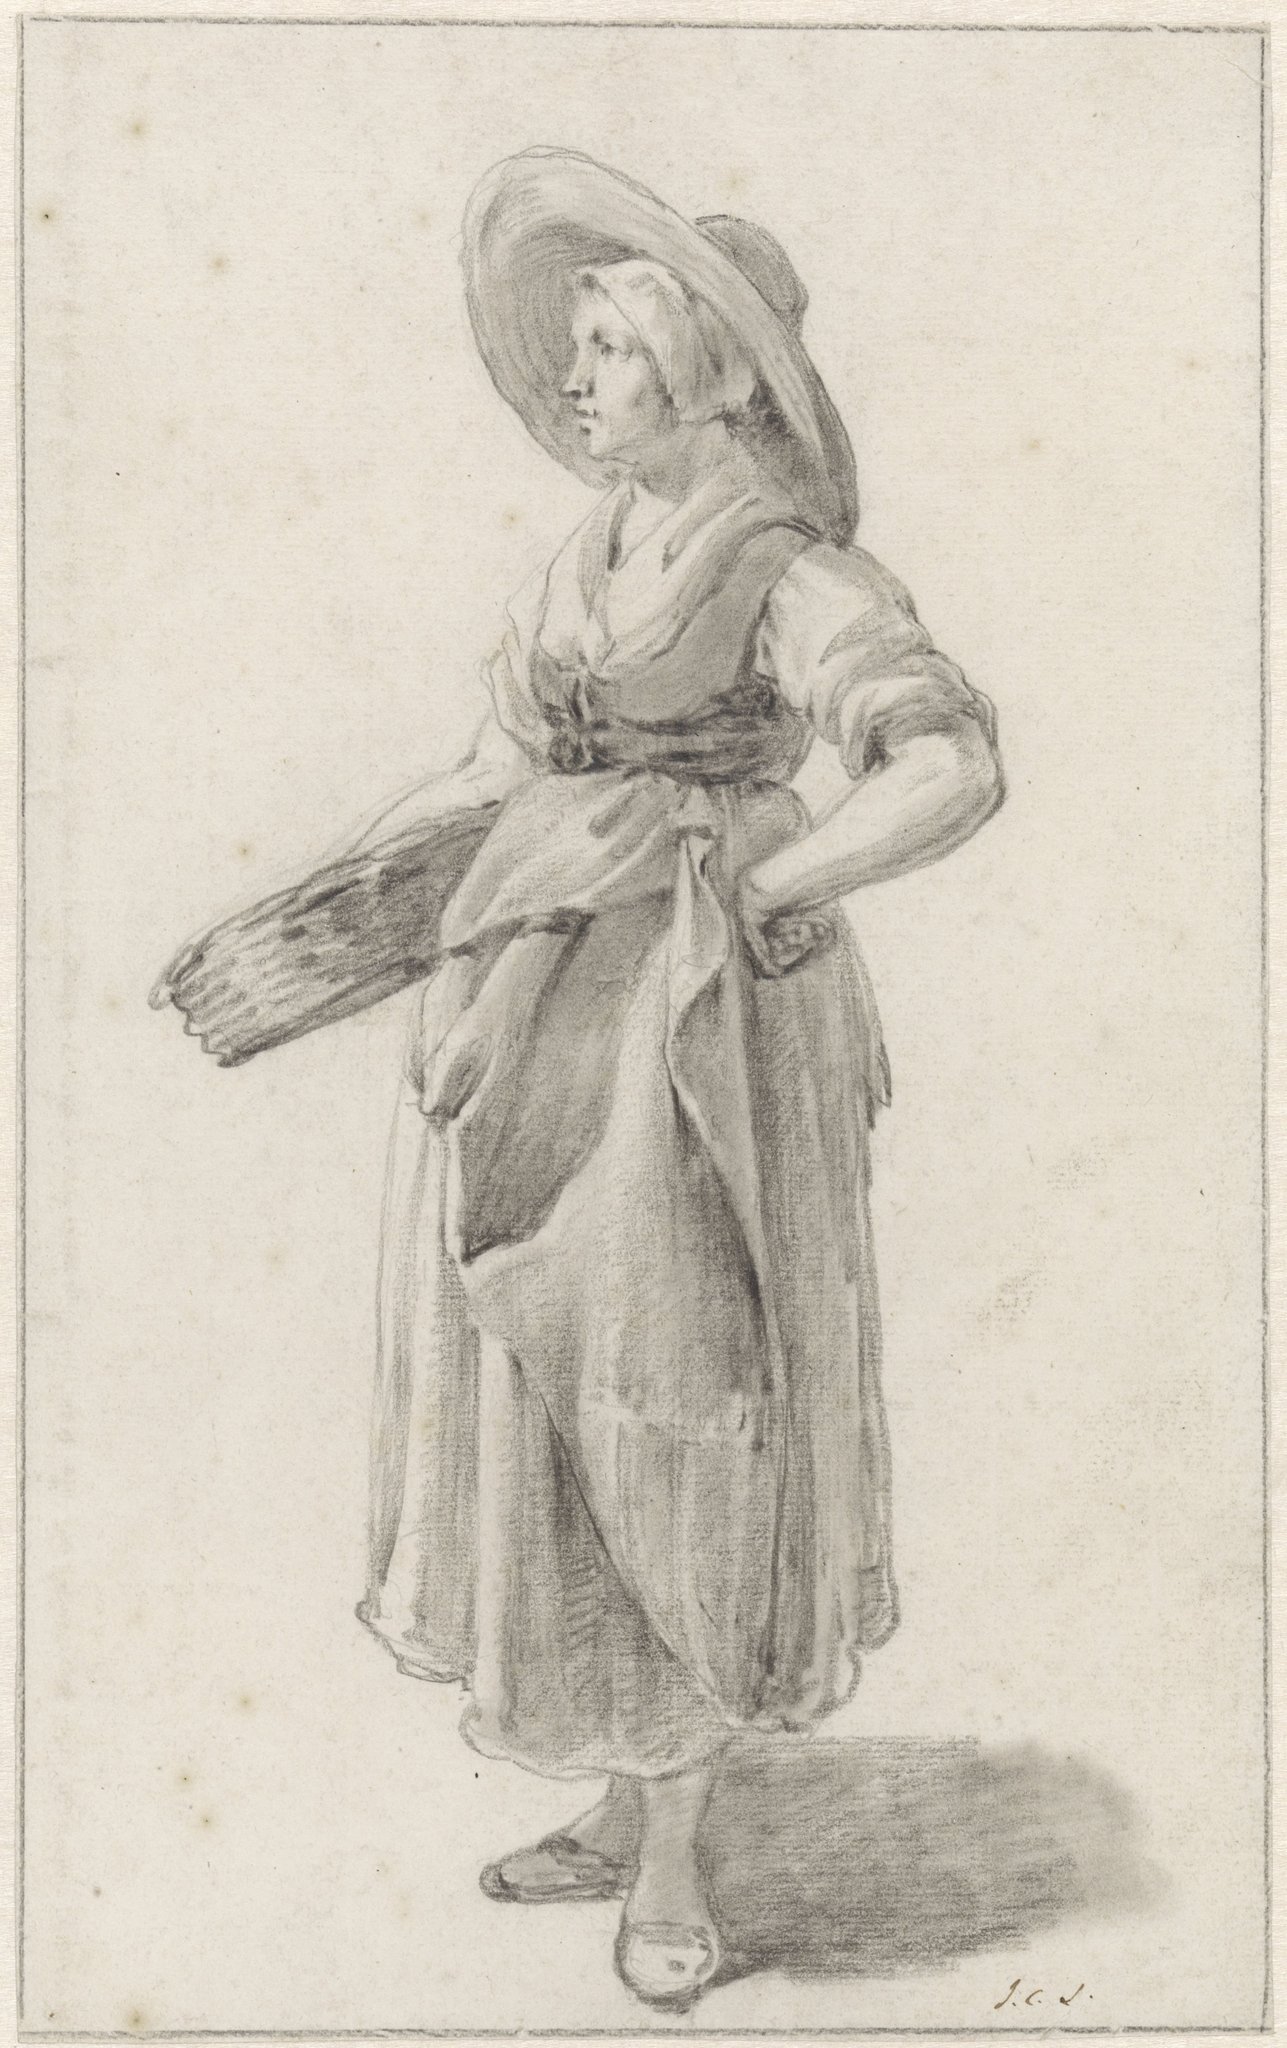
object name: drawing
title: Staande vrouw met hoed, die een mand draagt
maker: johannes christiaan schotel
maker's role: draughtsman, painter, print maker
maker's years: 1787-1838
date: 1797-1838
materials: chalk, paper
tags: standing figure, container made of plant material other than wood: basket